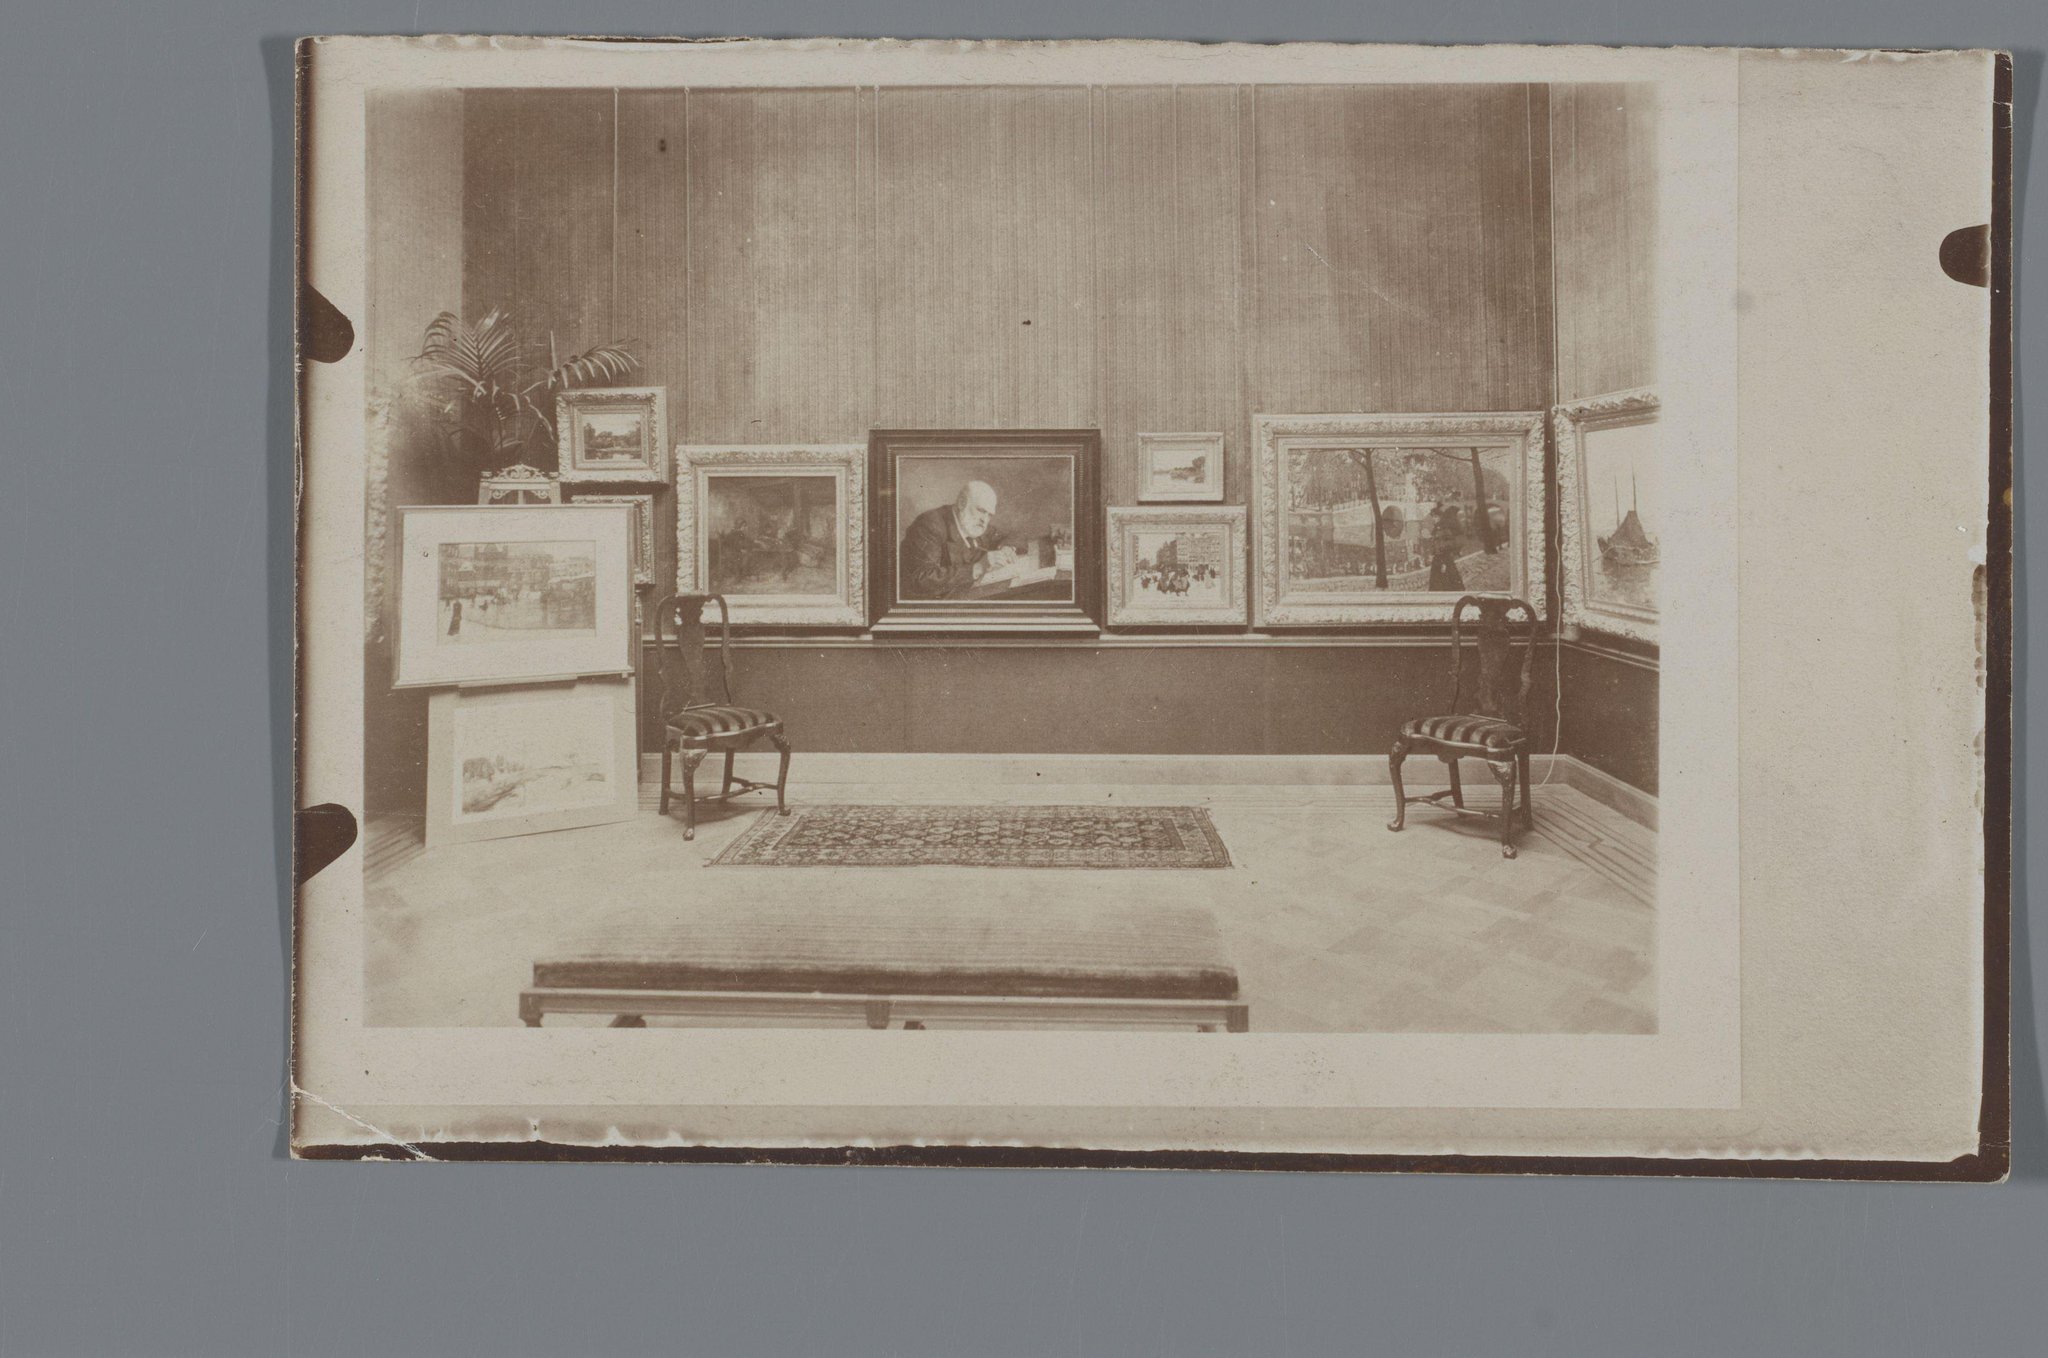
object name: photograph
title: Inrichting van een kunstzaal met schilderijen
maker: george hendrik breitner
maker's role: draughtsman, painter, print maker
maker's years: 1857-1923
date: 1895-1920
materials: photographic support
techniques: collodion silver print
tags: art collection, art gallery (+ painting), picture, painting